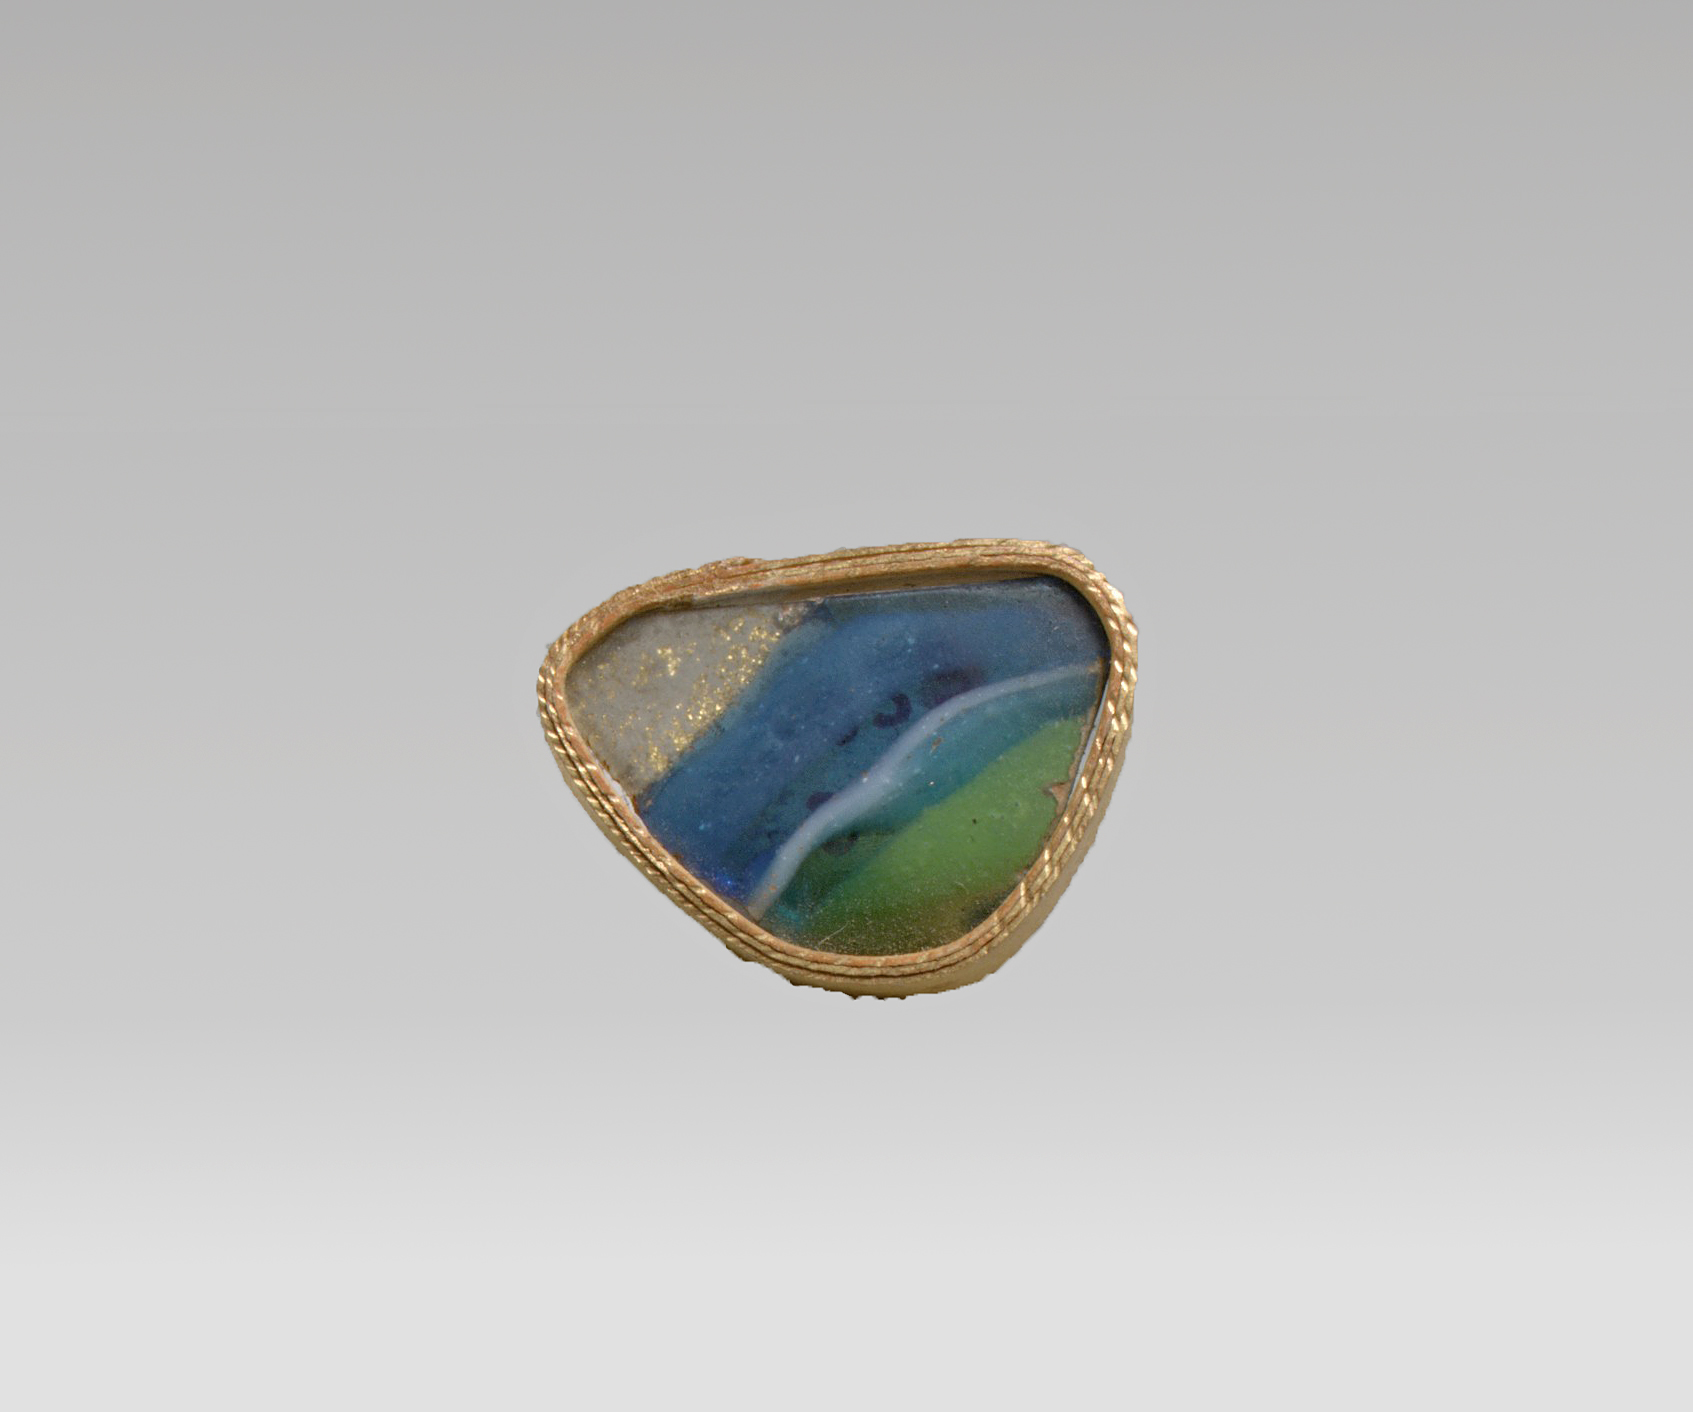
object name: fragment, gold band mosaic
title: Glass gold-band mosaic bowl fragment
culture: roman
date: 34 BCE-33 CE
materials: glass